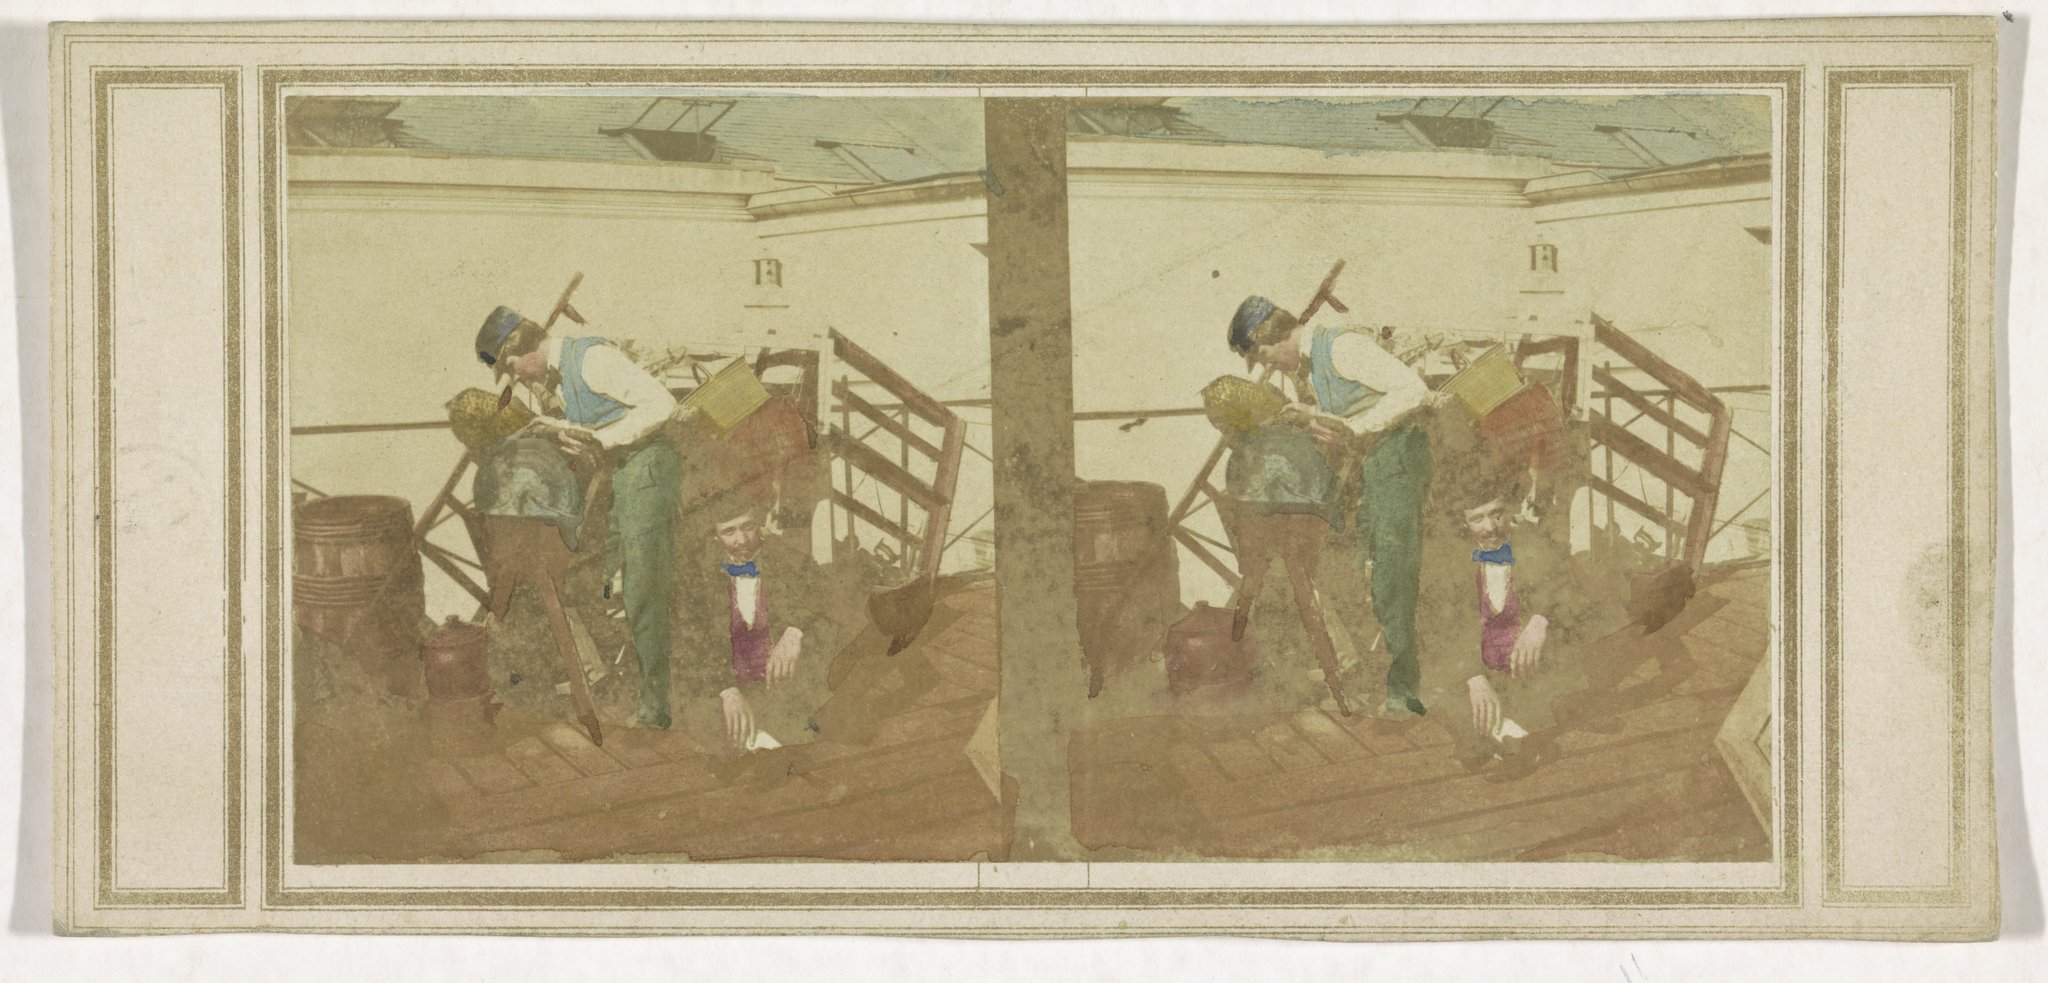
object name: stereograph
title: Staande man bij werktuig en hurkende man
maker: pierre-ambroise richebourg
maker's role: fotograaf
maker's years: 1810-1875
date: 1850-1870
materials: photographic support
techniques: albumen print, hand coloring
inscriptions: number: ‘2’, check stamp: ‘monogram LM (?)’, number: ‘167’